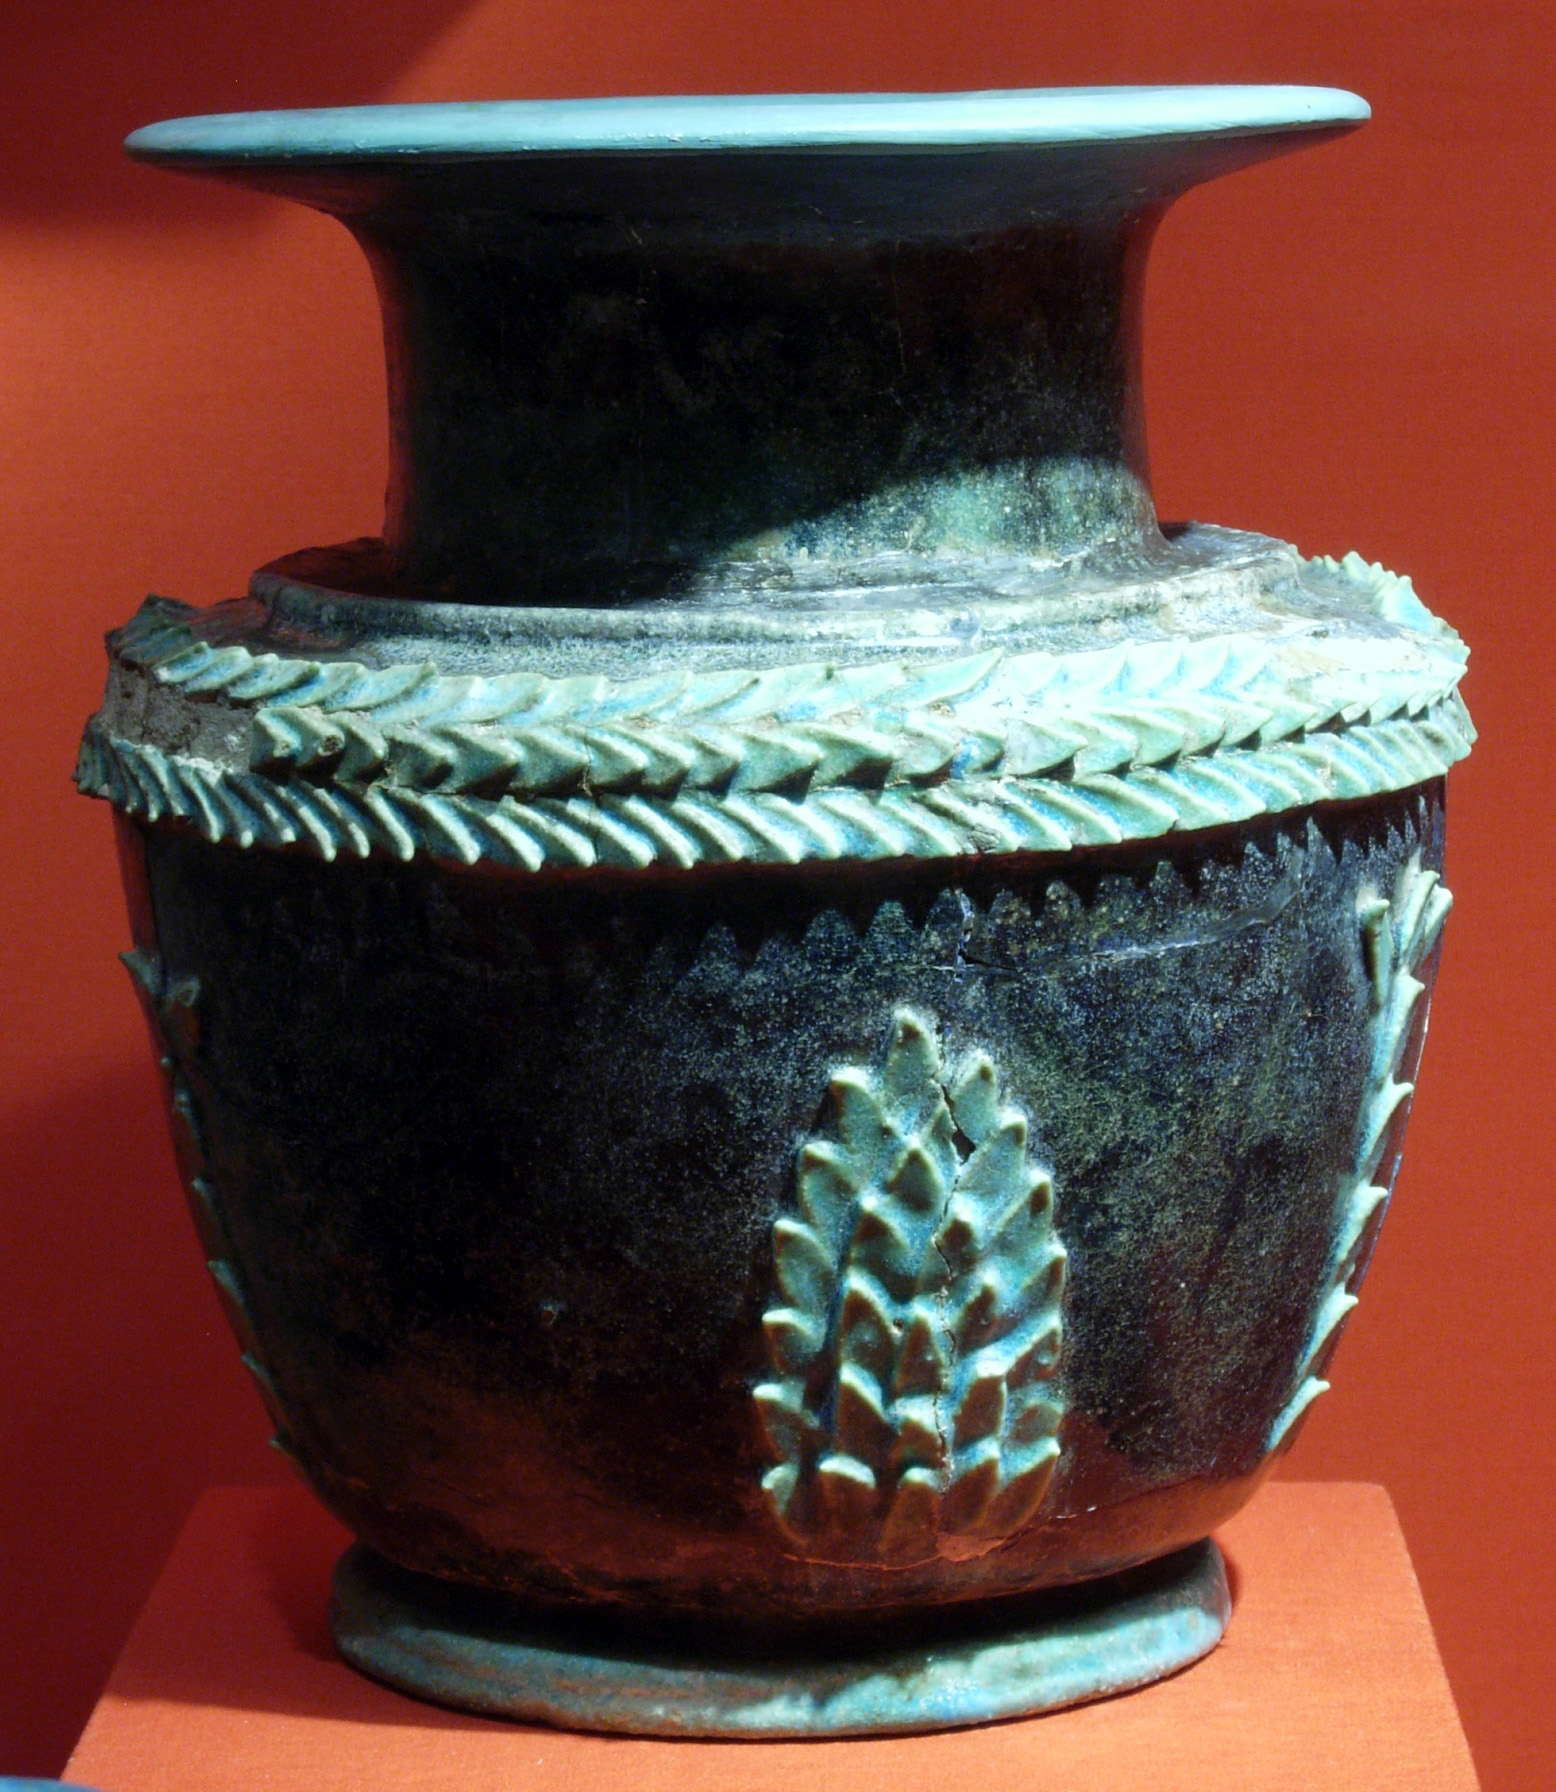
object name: vase, painted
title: Decorated Vase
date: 1-100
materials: faience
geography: egypt